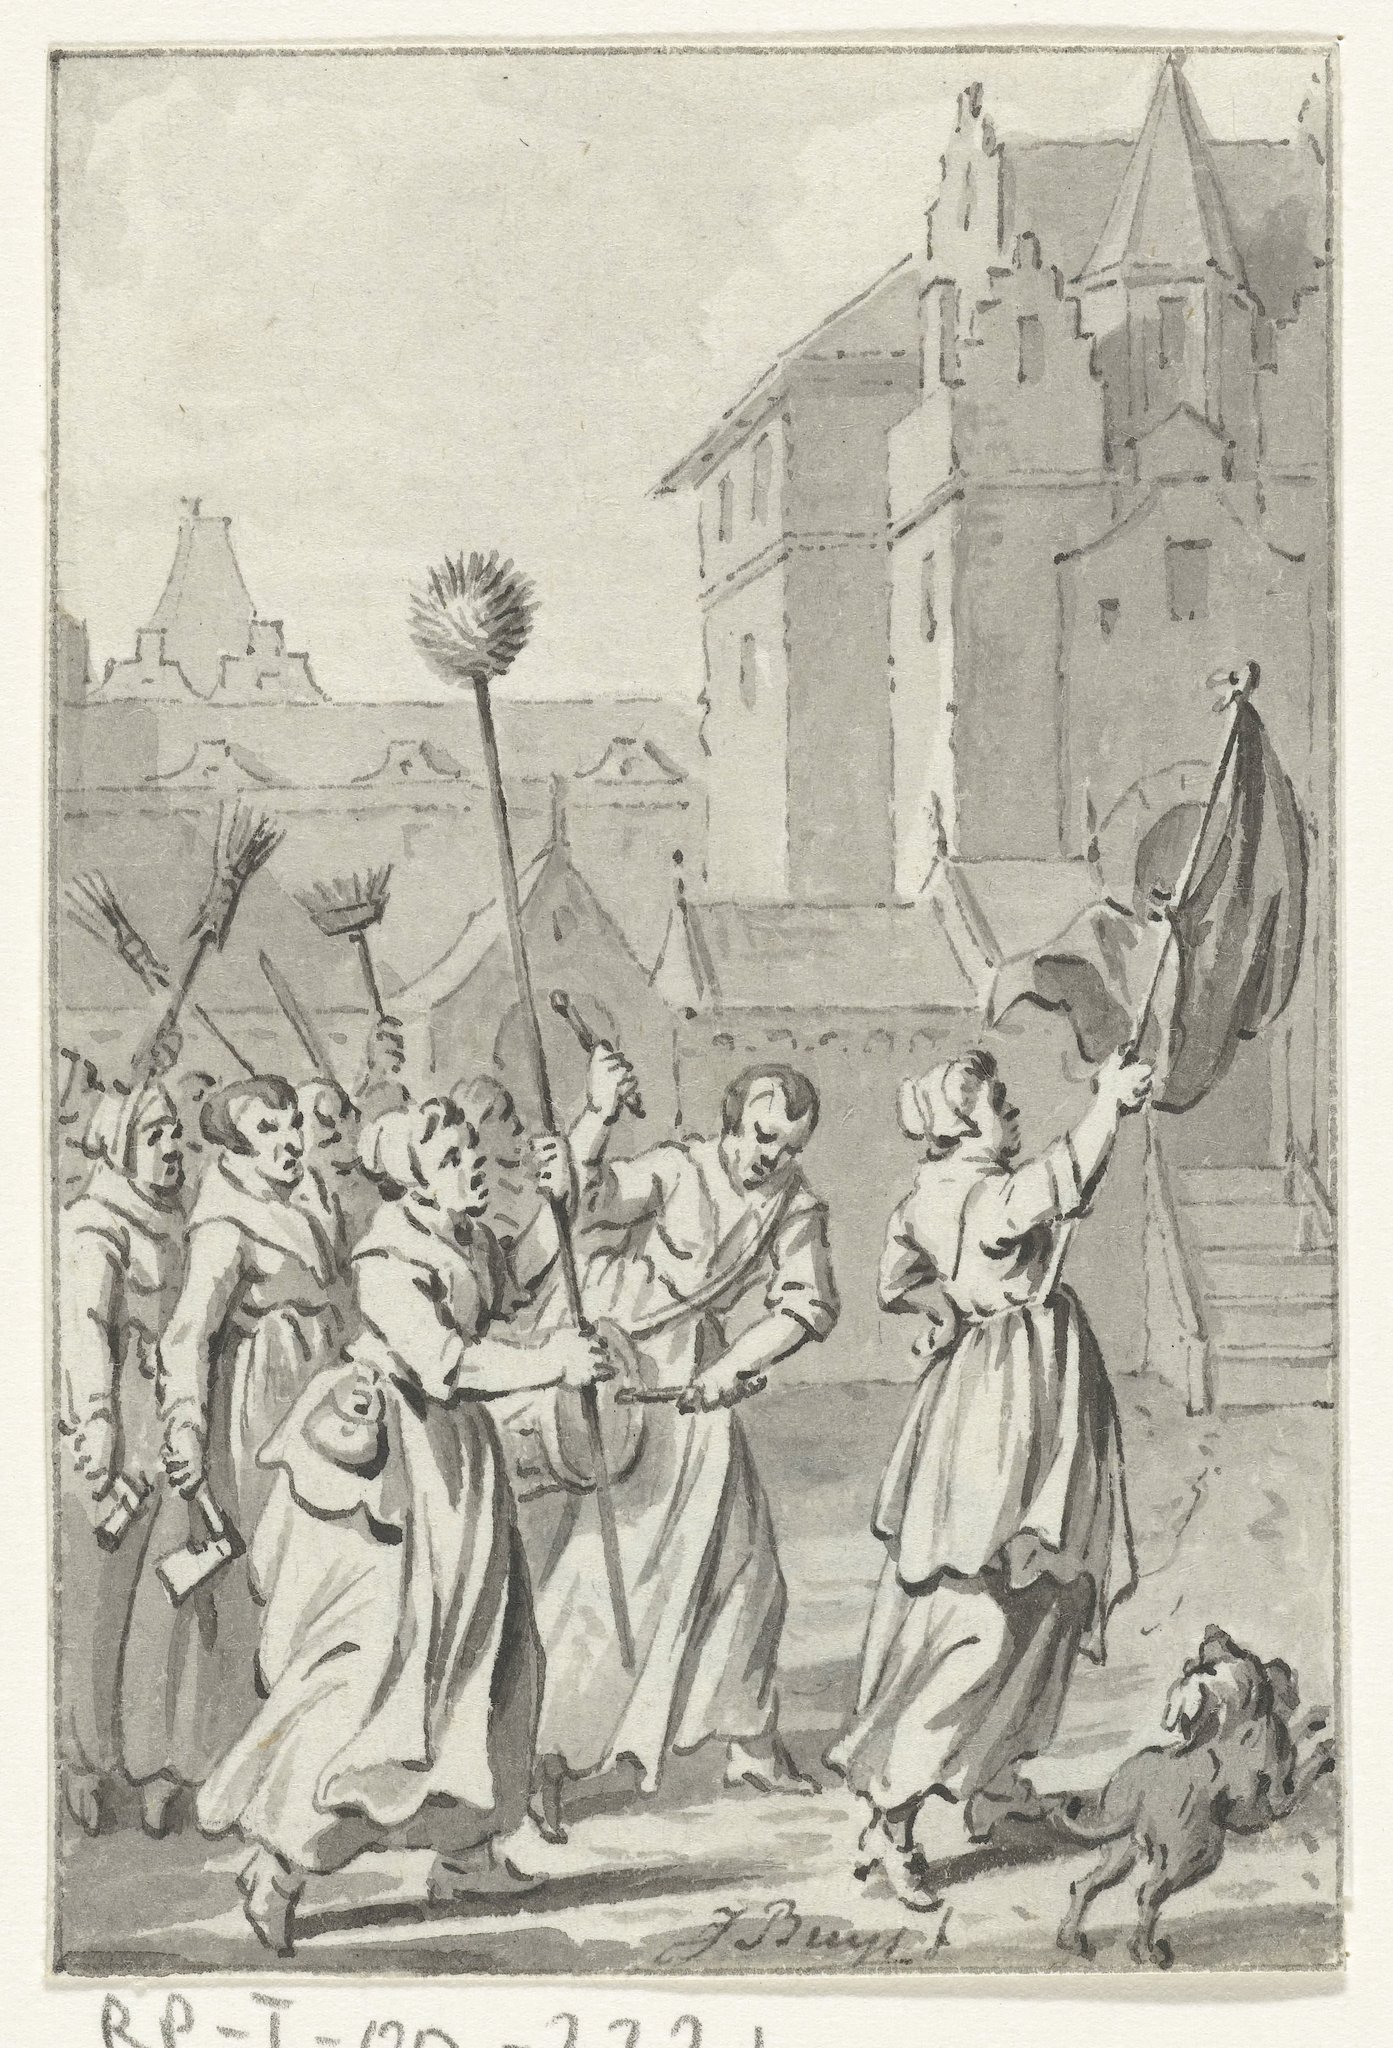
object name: historieplaat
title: Trijn Leemput trekt met Utrechtse vrouwen op om slot Vredenburg te slechten, februari 1577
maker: jacobus buys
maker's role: draughtsman, print maker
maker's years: 1724-1801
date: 1780-1795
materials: ink, paper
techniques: brush, pen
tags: utrecht, historical persons - bb - woman, protest, historical events and situations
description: Trijn van Leemput trekt met een groepje vrouwen gewapend met hamers en pikhouwelen op naar het kasteel Vredenburg, 2 mei 1577. Voorop loopt een vrouw met een vlag, daarachter een vrouw die op een trom slaat en een vrouw met een ragebol. Ontwerp voor een prent.